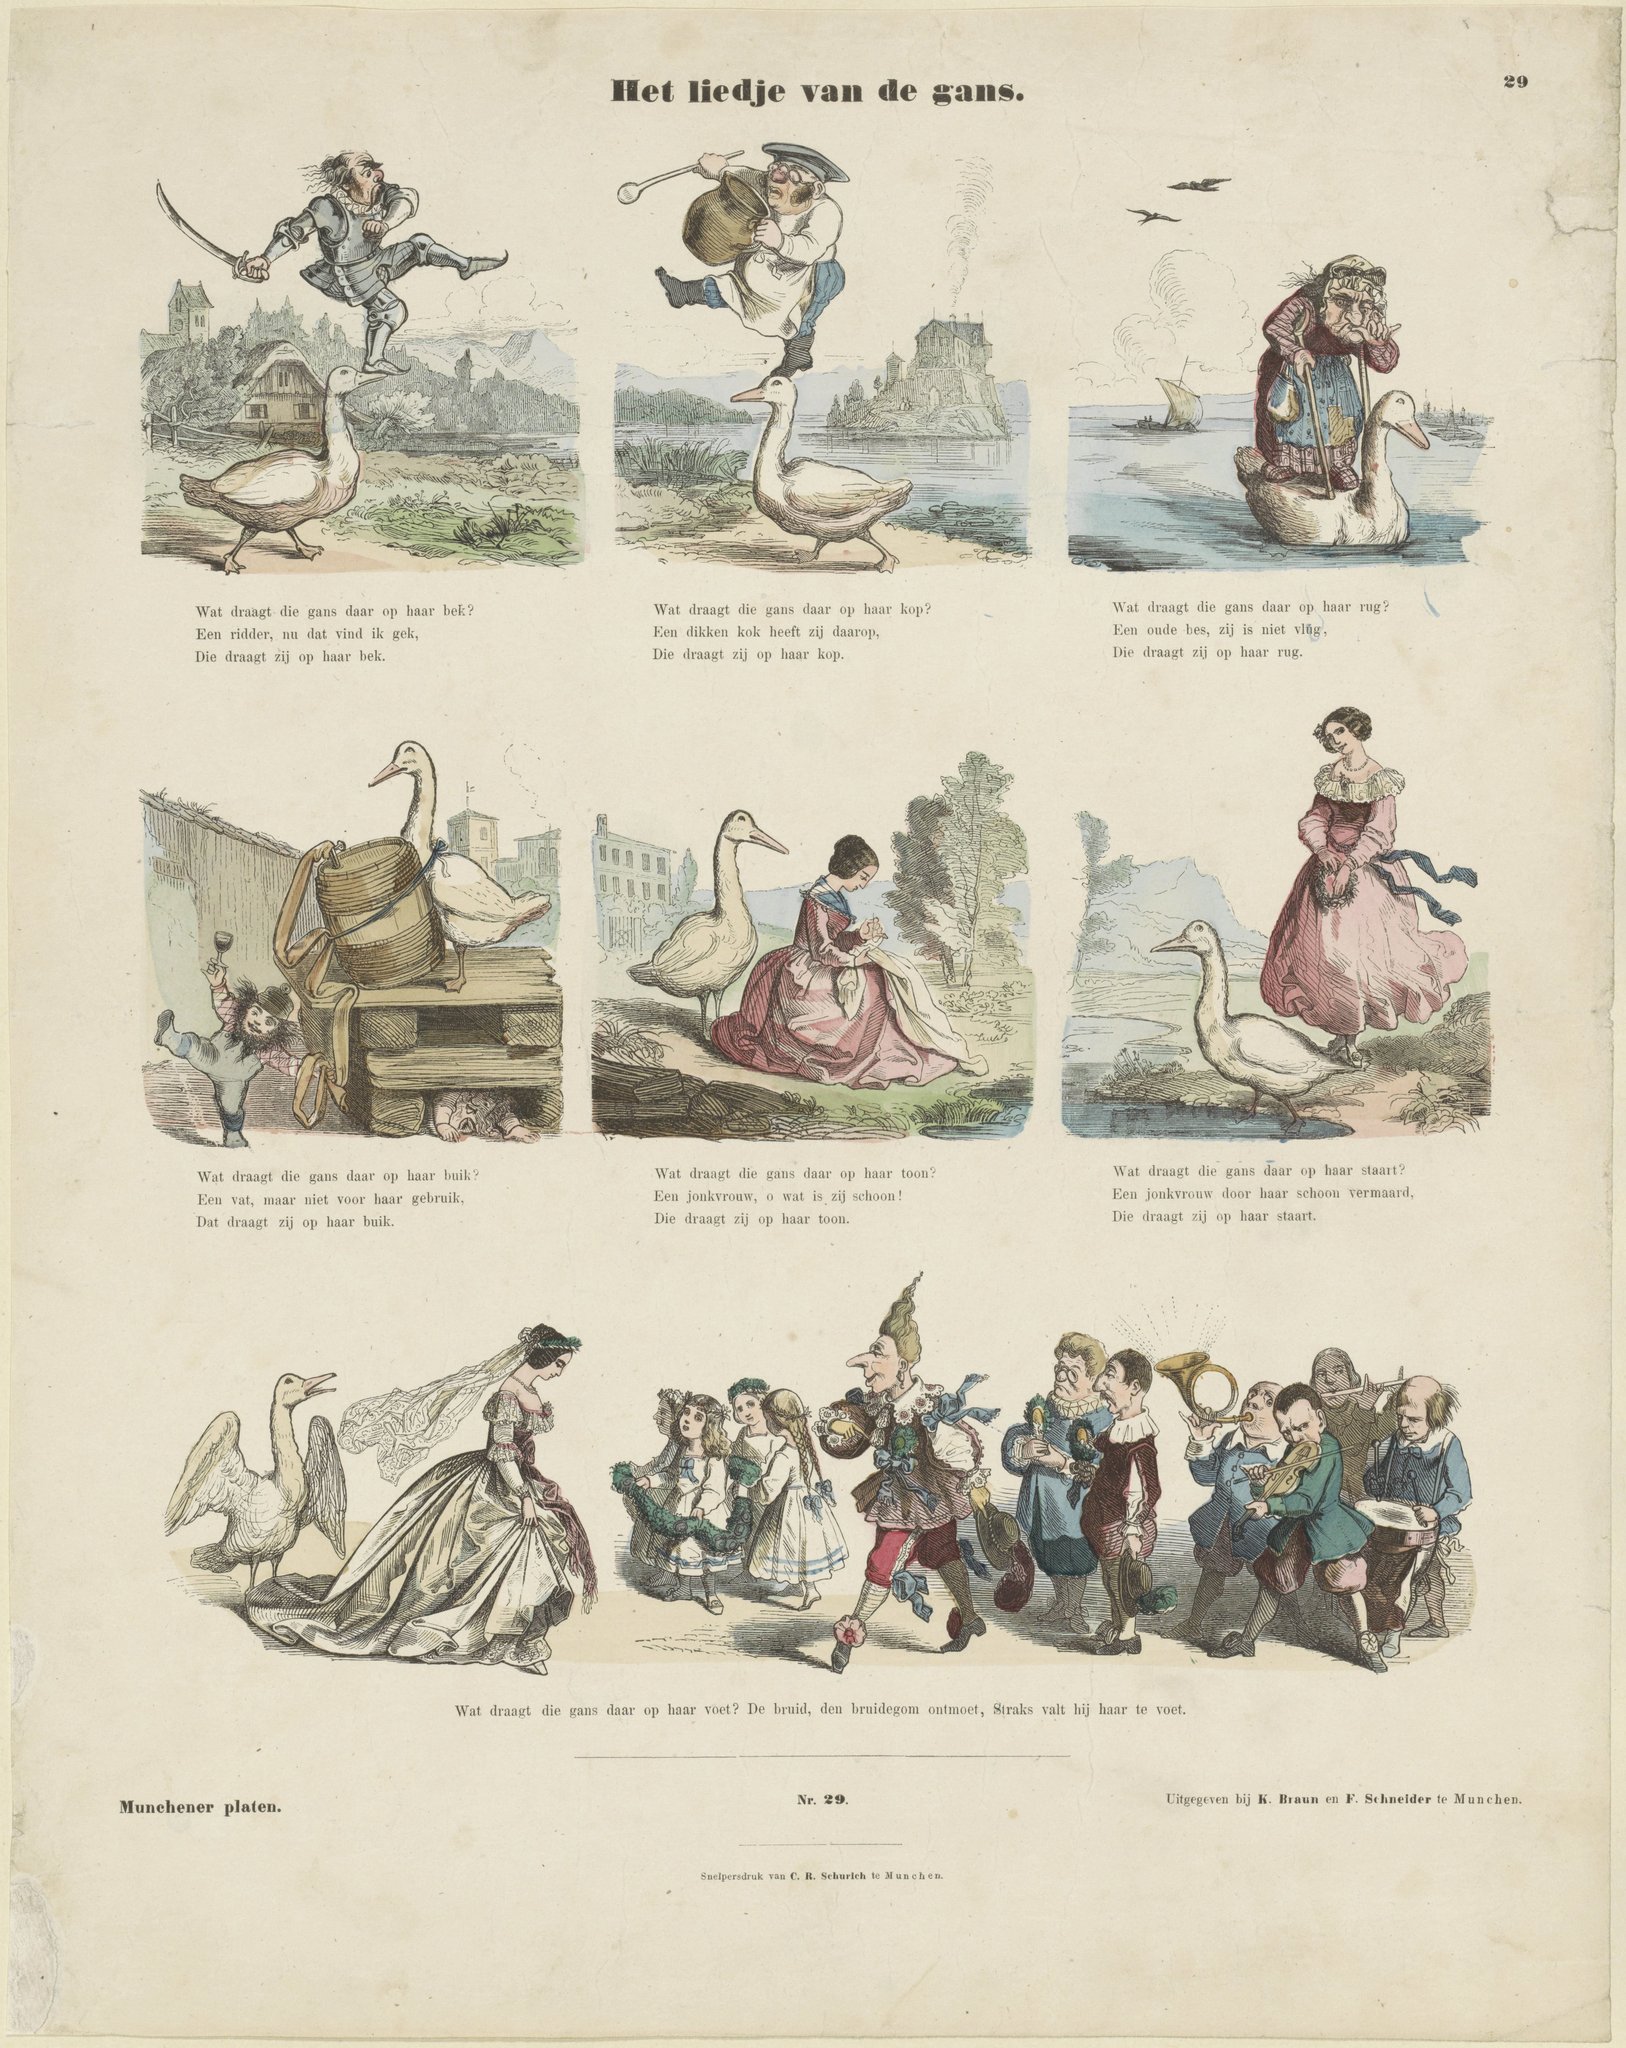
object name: print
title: Munchener platen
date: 1843-1920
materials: paper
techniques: colour, letterpress printing, engraving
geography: munich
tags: water-birds: goose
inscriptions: collector's mark: Lugt 2760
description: Blad met 7 taferelen met een gans. Onder elke afbeelding een onderschrift. Genummerd midden onder: Nr. 29. Genummerd rechtsboven: 29.